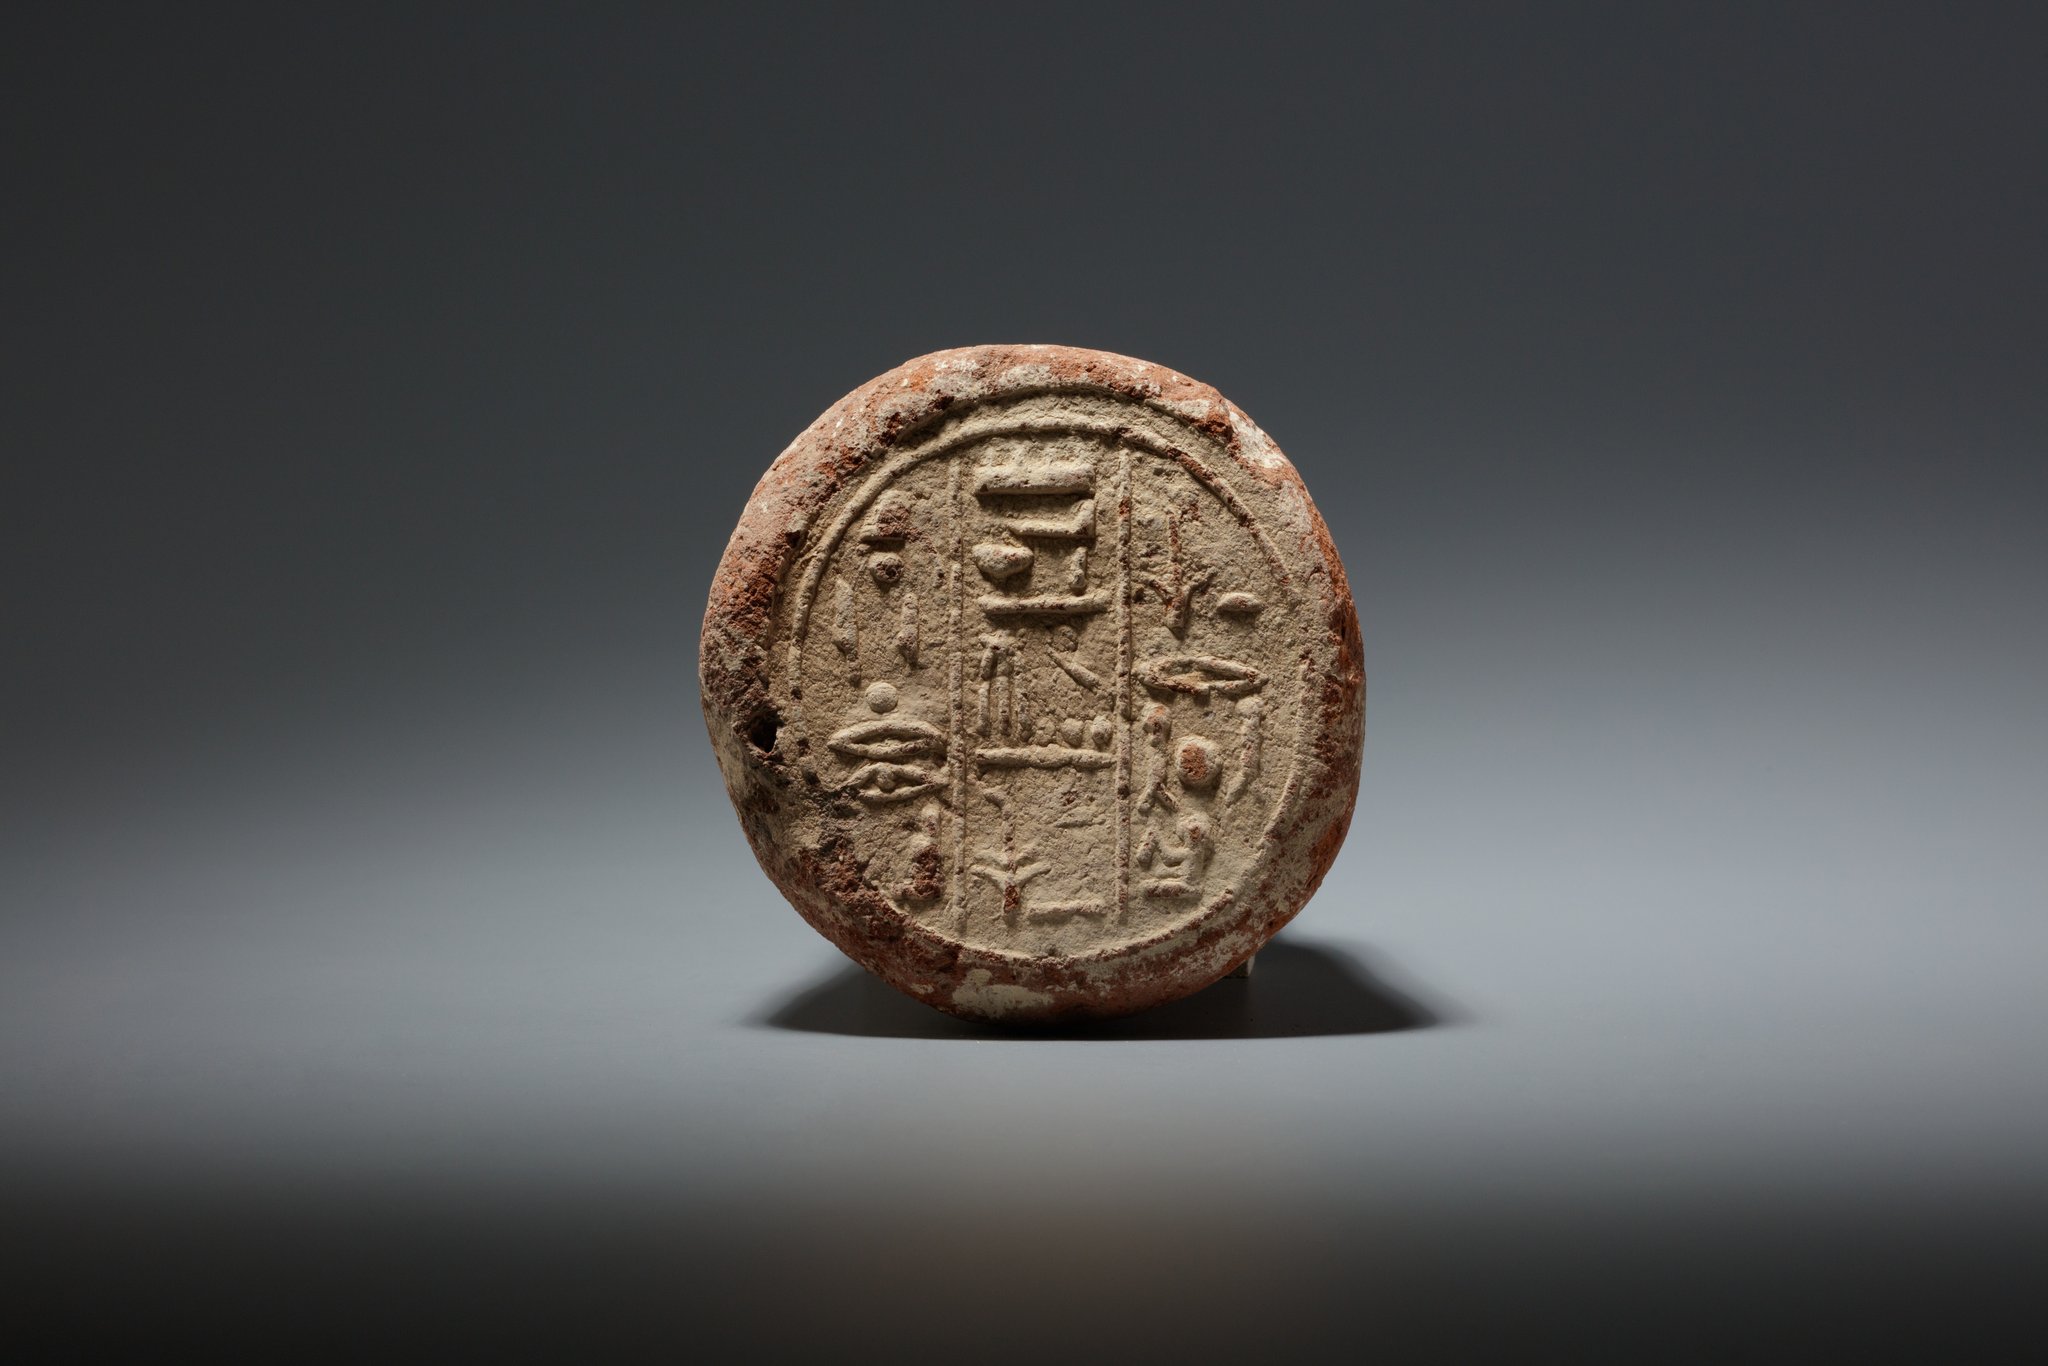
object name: cone, davy 159, nesuterneheh, tutor, royal child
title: Funerary Cone of the Tutor of the Royal Children Nesuterneheh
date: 1550-1295 BCE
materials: pottery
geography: egypt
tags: hieroglyphs